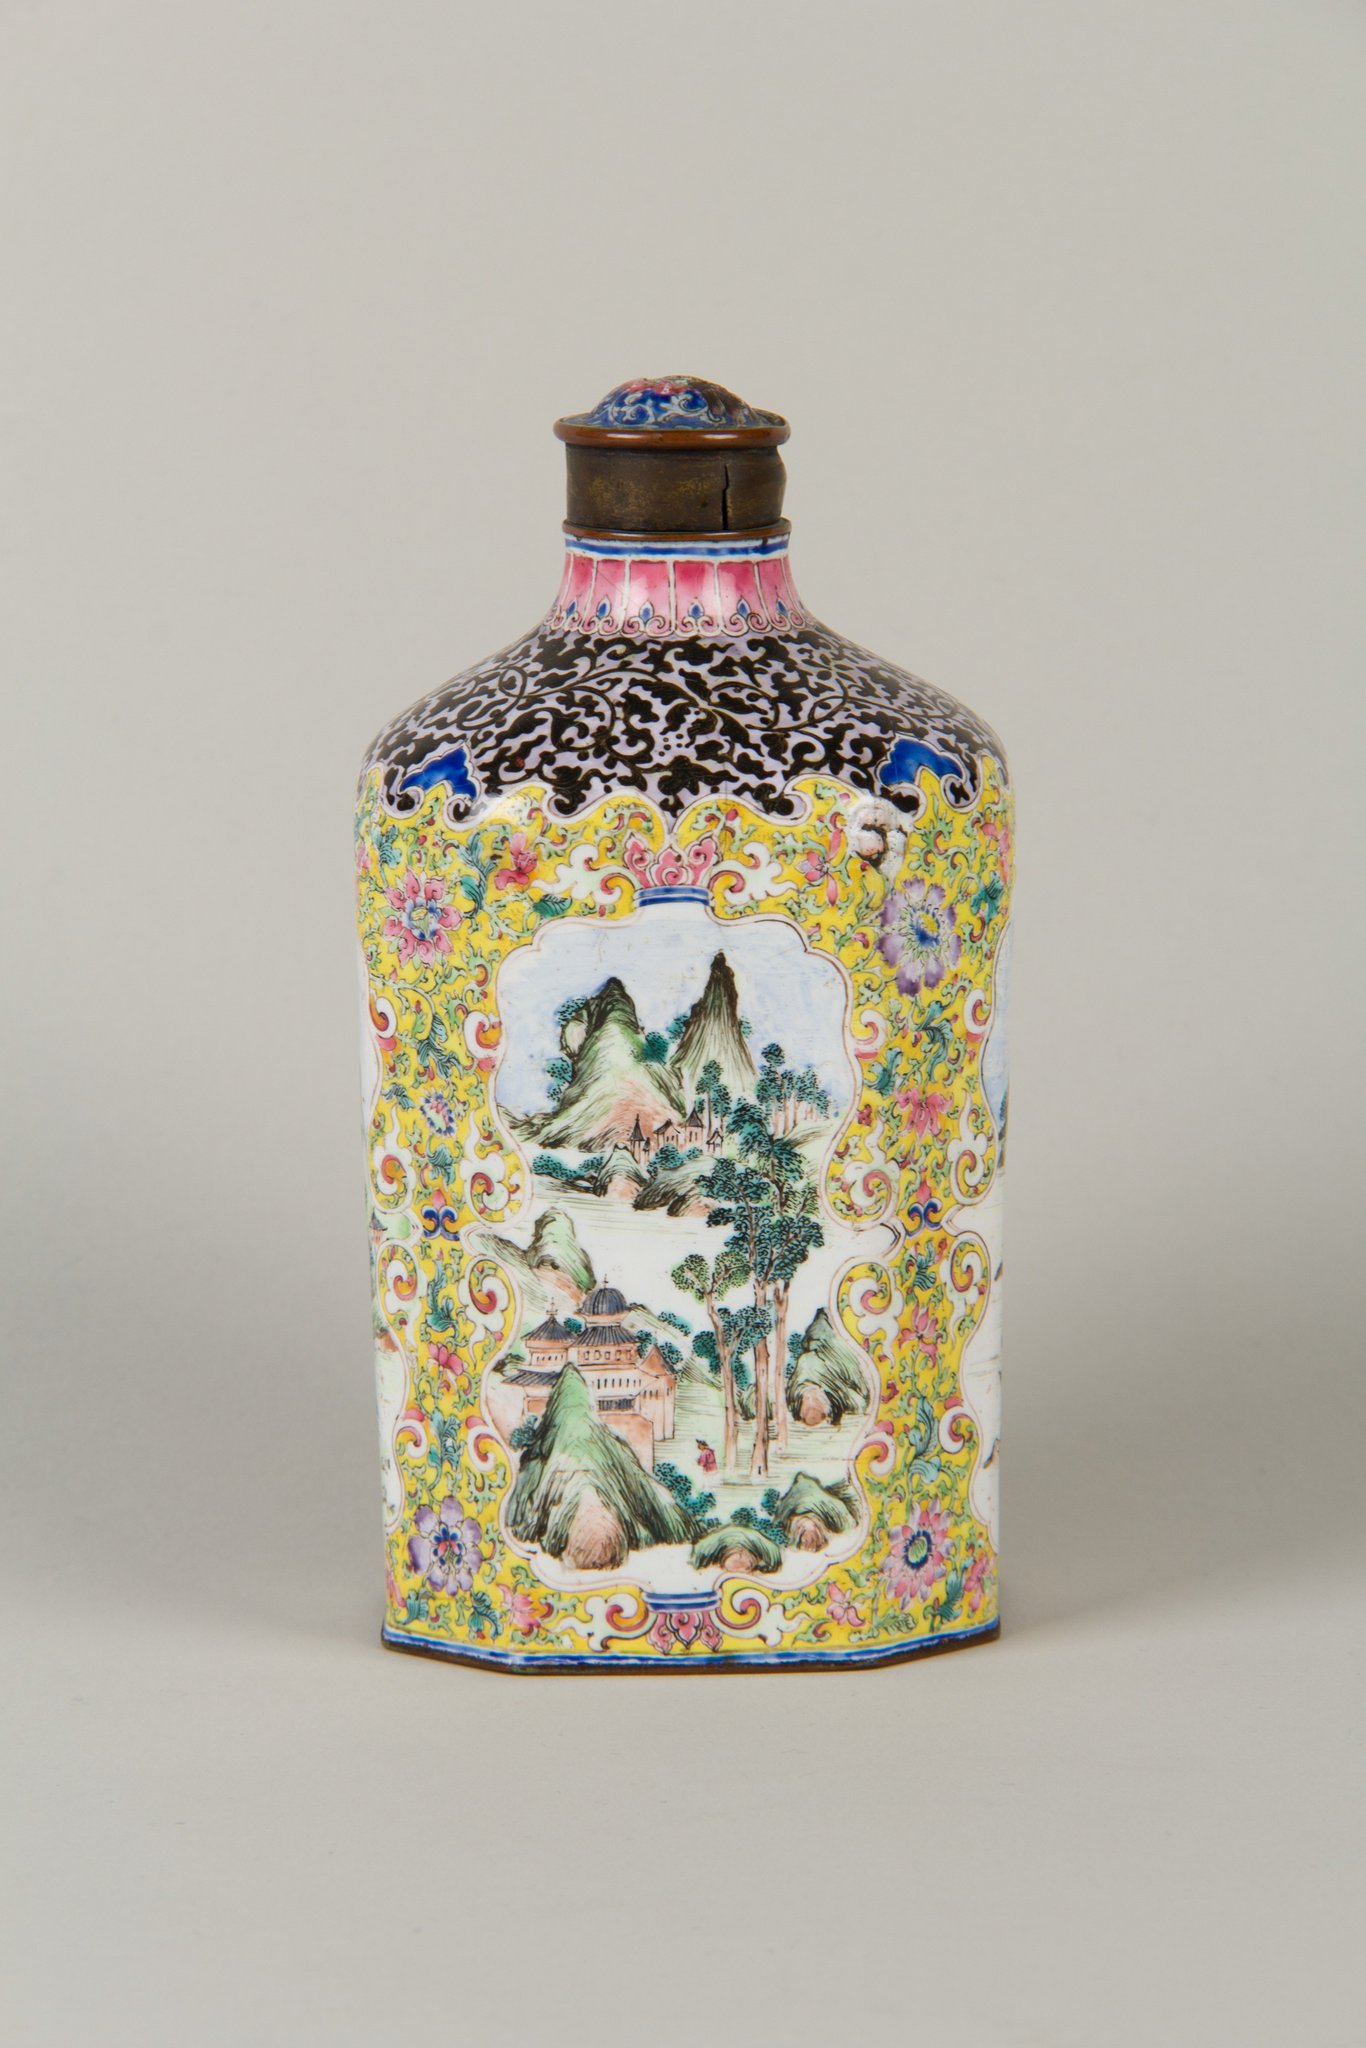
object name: bottle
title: Bottle and stopper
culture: chinese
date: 1736-1795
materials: copper, enamel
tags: hills,trees